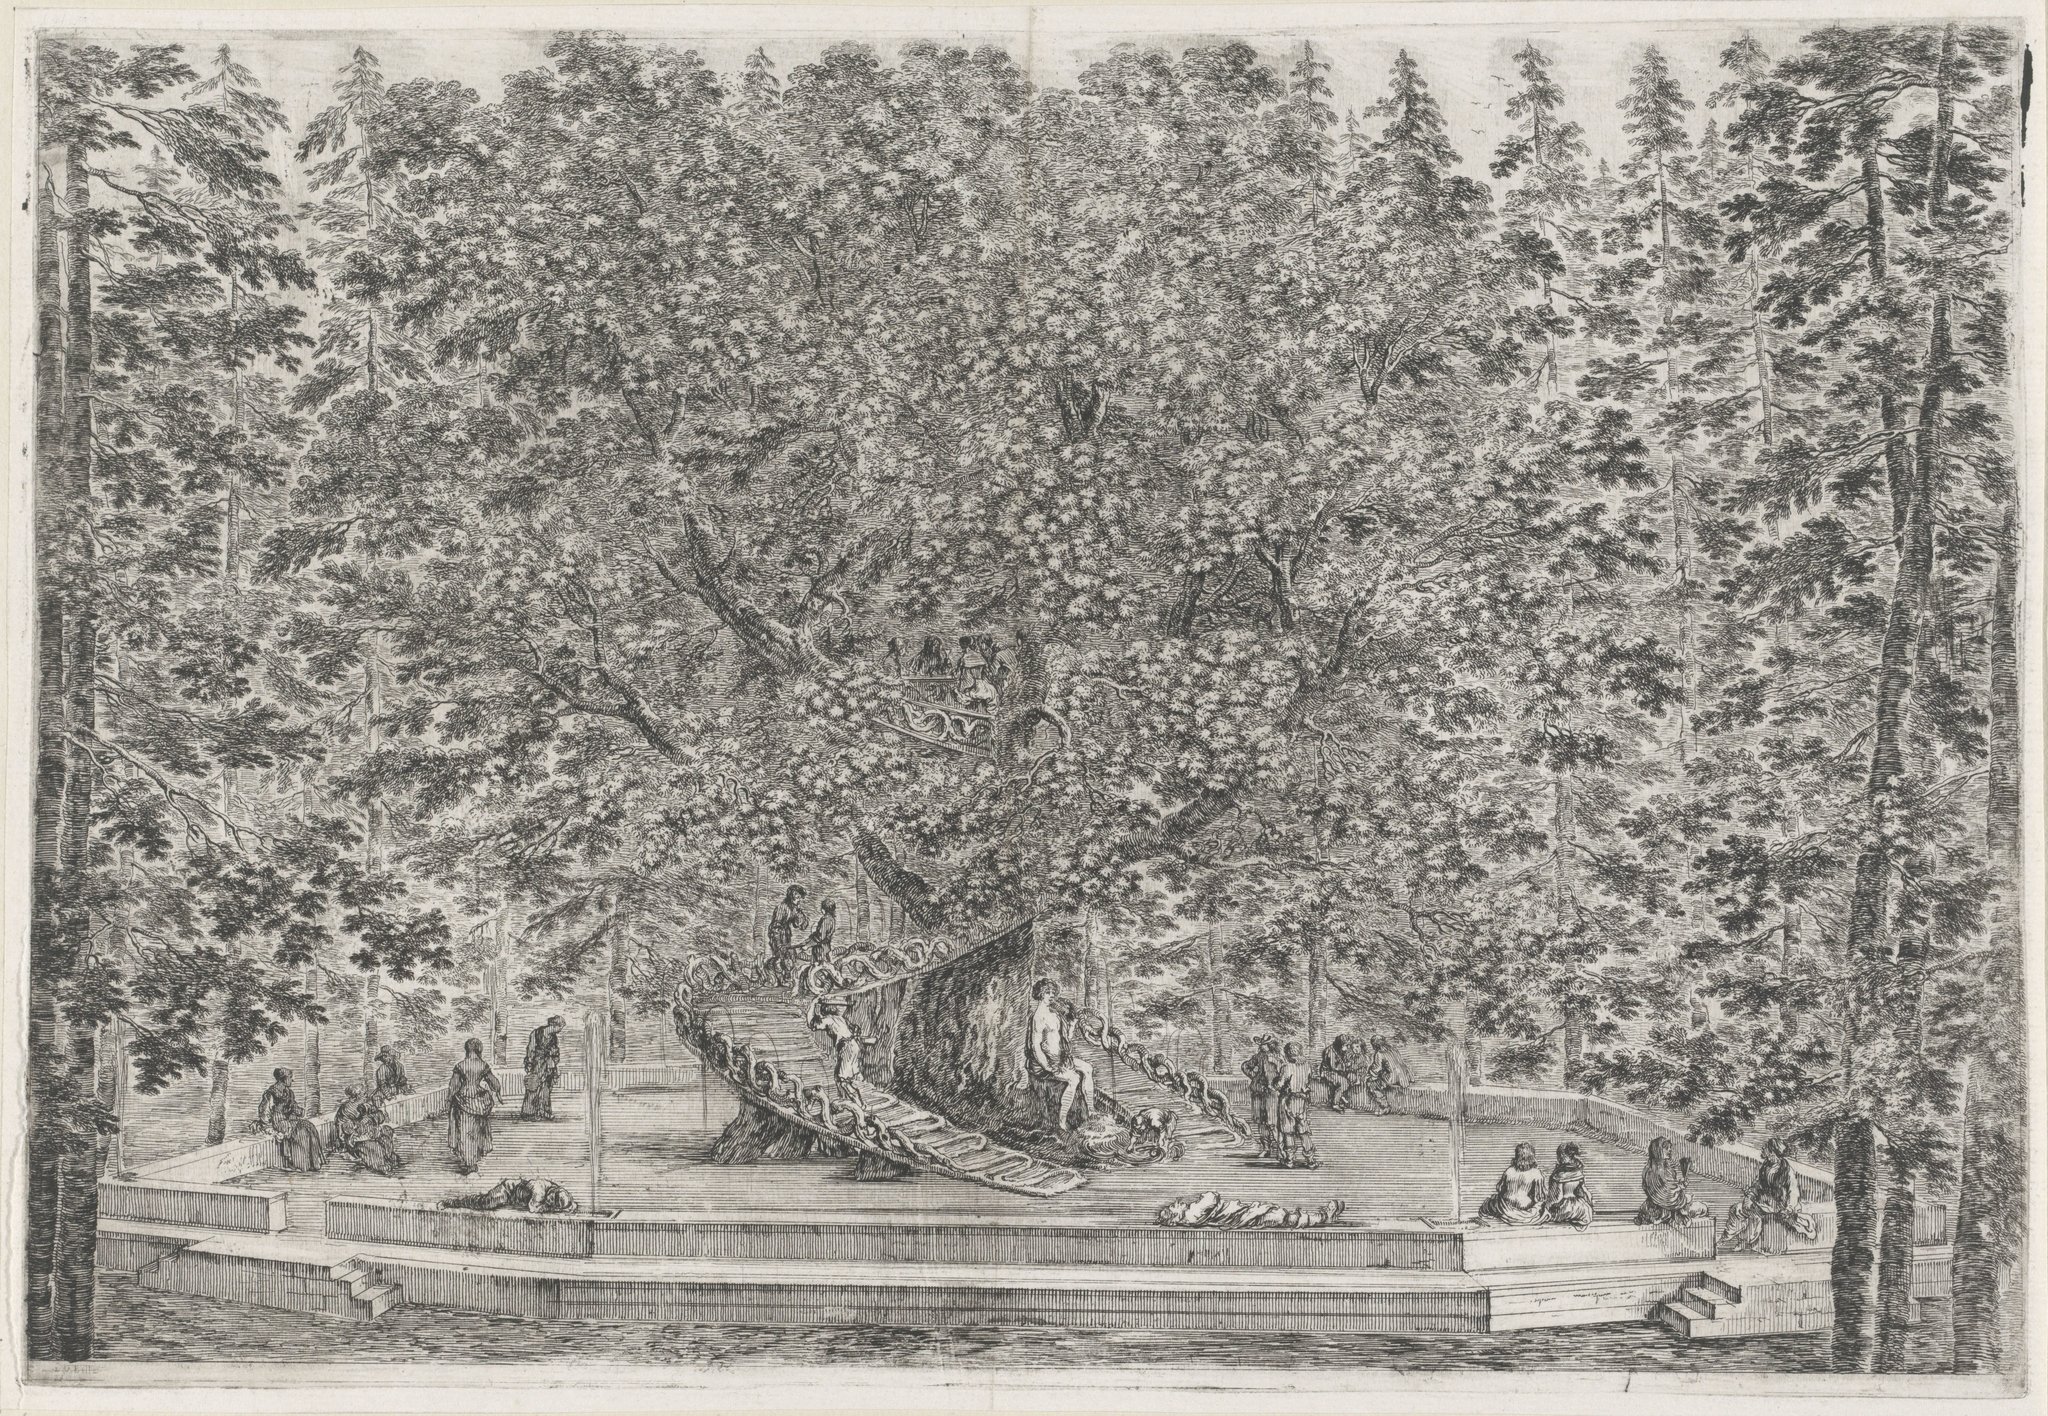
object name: ornament print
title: De bewoonde boom in de tuin van Villa Pratolino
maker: stefano della bella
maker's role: draughtsman, print maker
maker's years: 1610-1664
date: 1620-1664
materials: paper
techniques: etching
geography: italy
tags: trees, garden, climbing up a tree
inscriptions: collector's mark: Lugt 240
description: De zogenaamde bewoonde boom in de tuin van Villa Pratolino, de villa van Francesco I de'Medici. Een wenteltrap gaat omhoog in een grote oude boom, waardoor mensen eenvoudig in de boom kunnen klimmen. Rondom de boom rustende figuren op muurtjes.